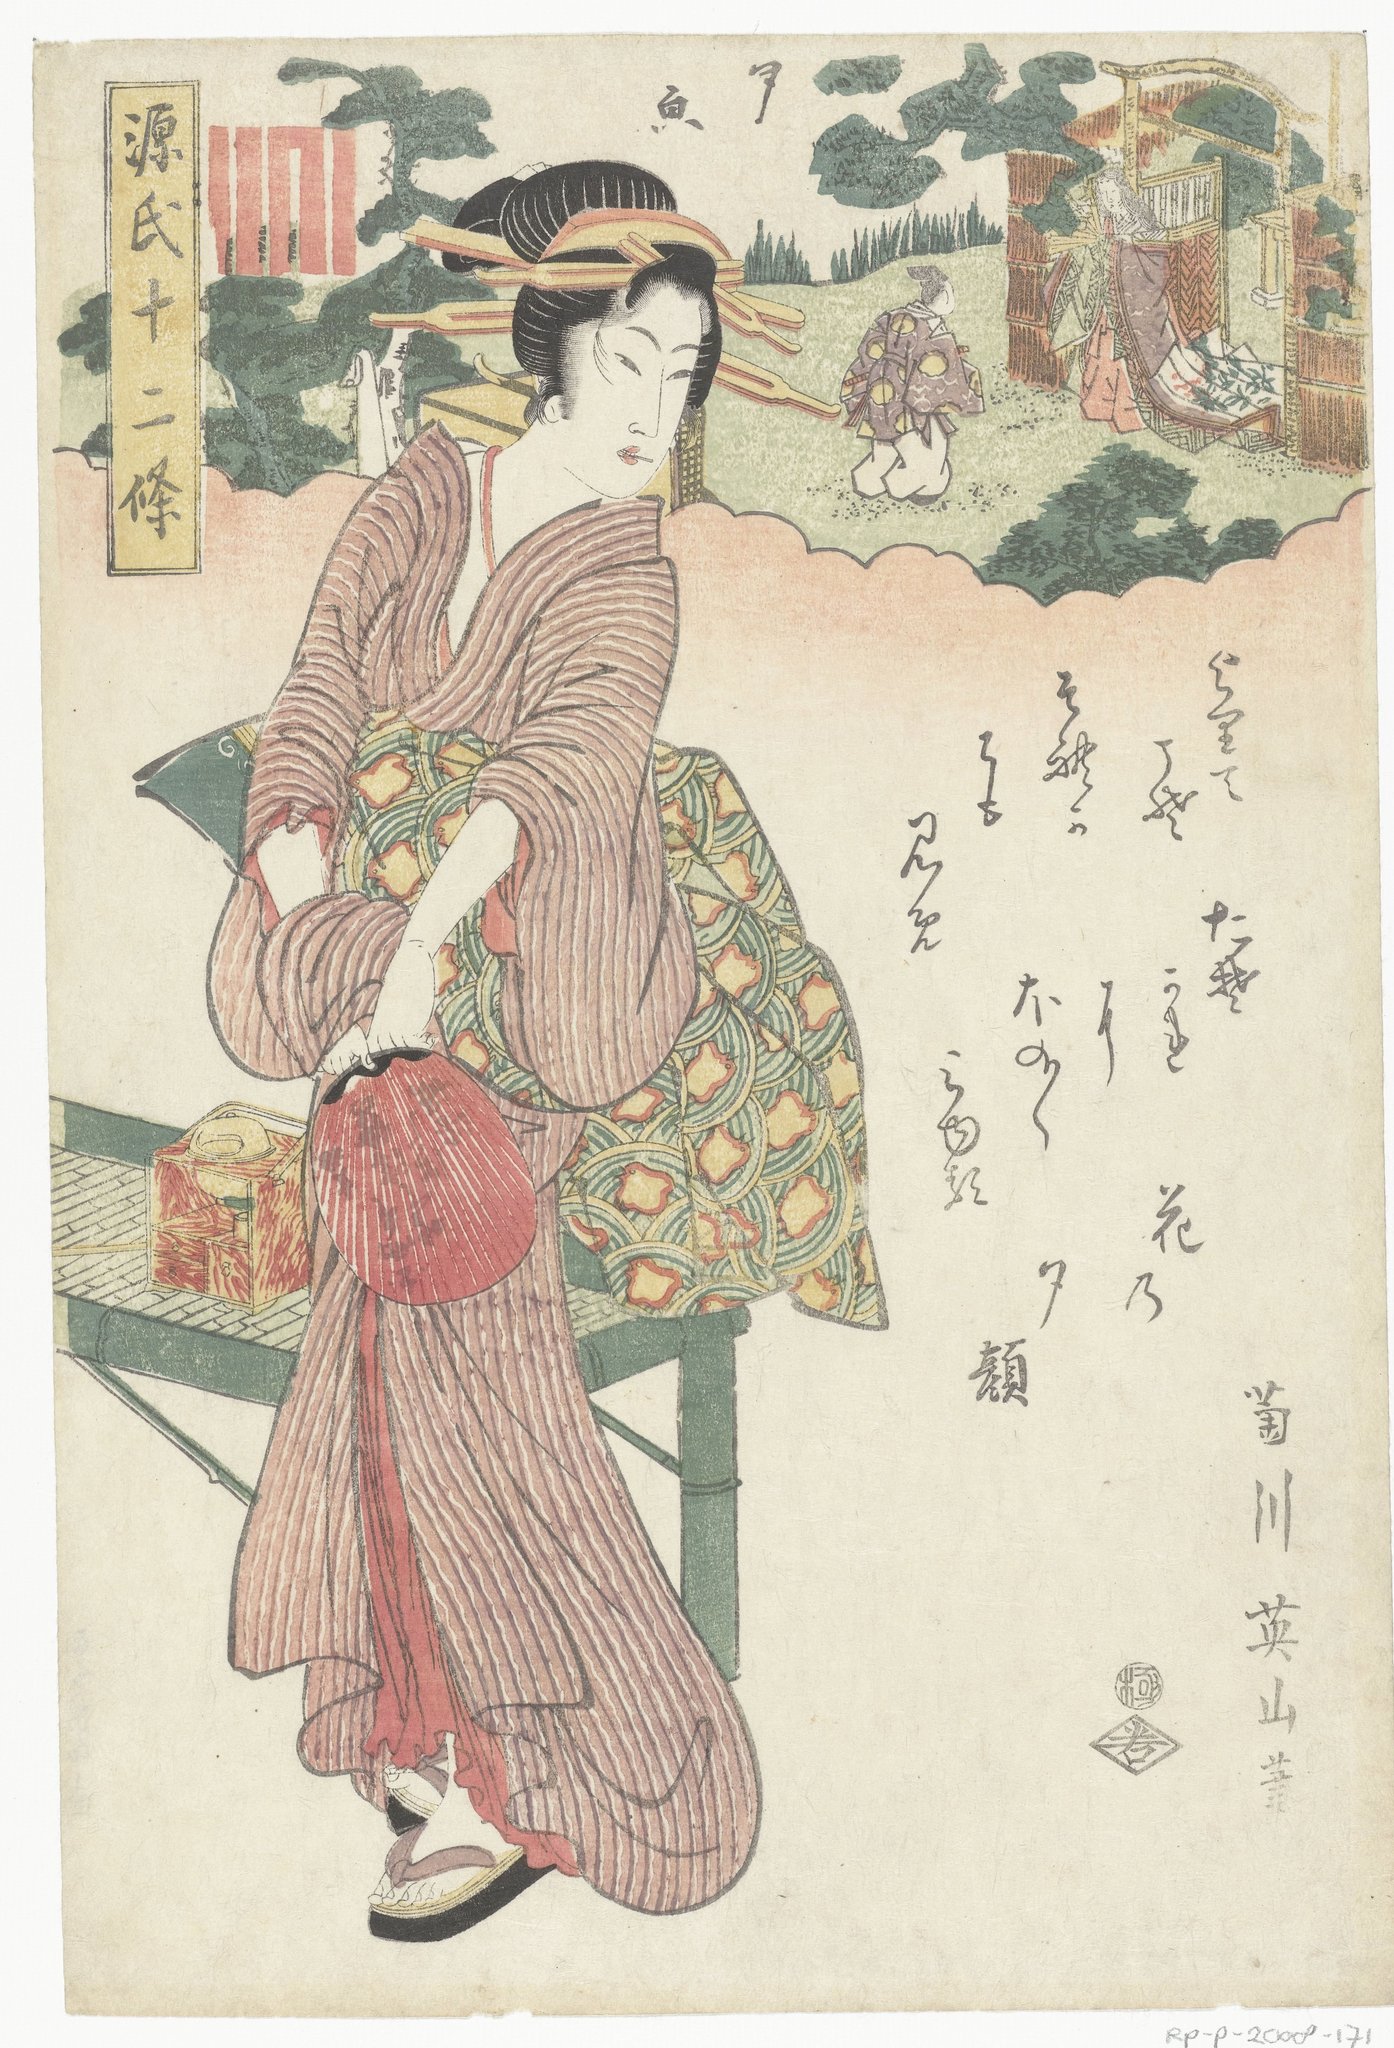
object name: print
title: Yugao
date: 1810-1830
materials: paper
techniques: woodcut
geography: japan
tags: adult woman, fan, landscapes (+ landscape with figures, staffage)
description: Courtisane met rode waaier in de handen, staand bij bamboe bankje. Achtergrondscene met ontmoeting tussen man (prins Genji) en vrouw (Yugao) staand in open poort van omheining.